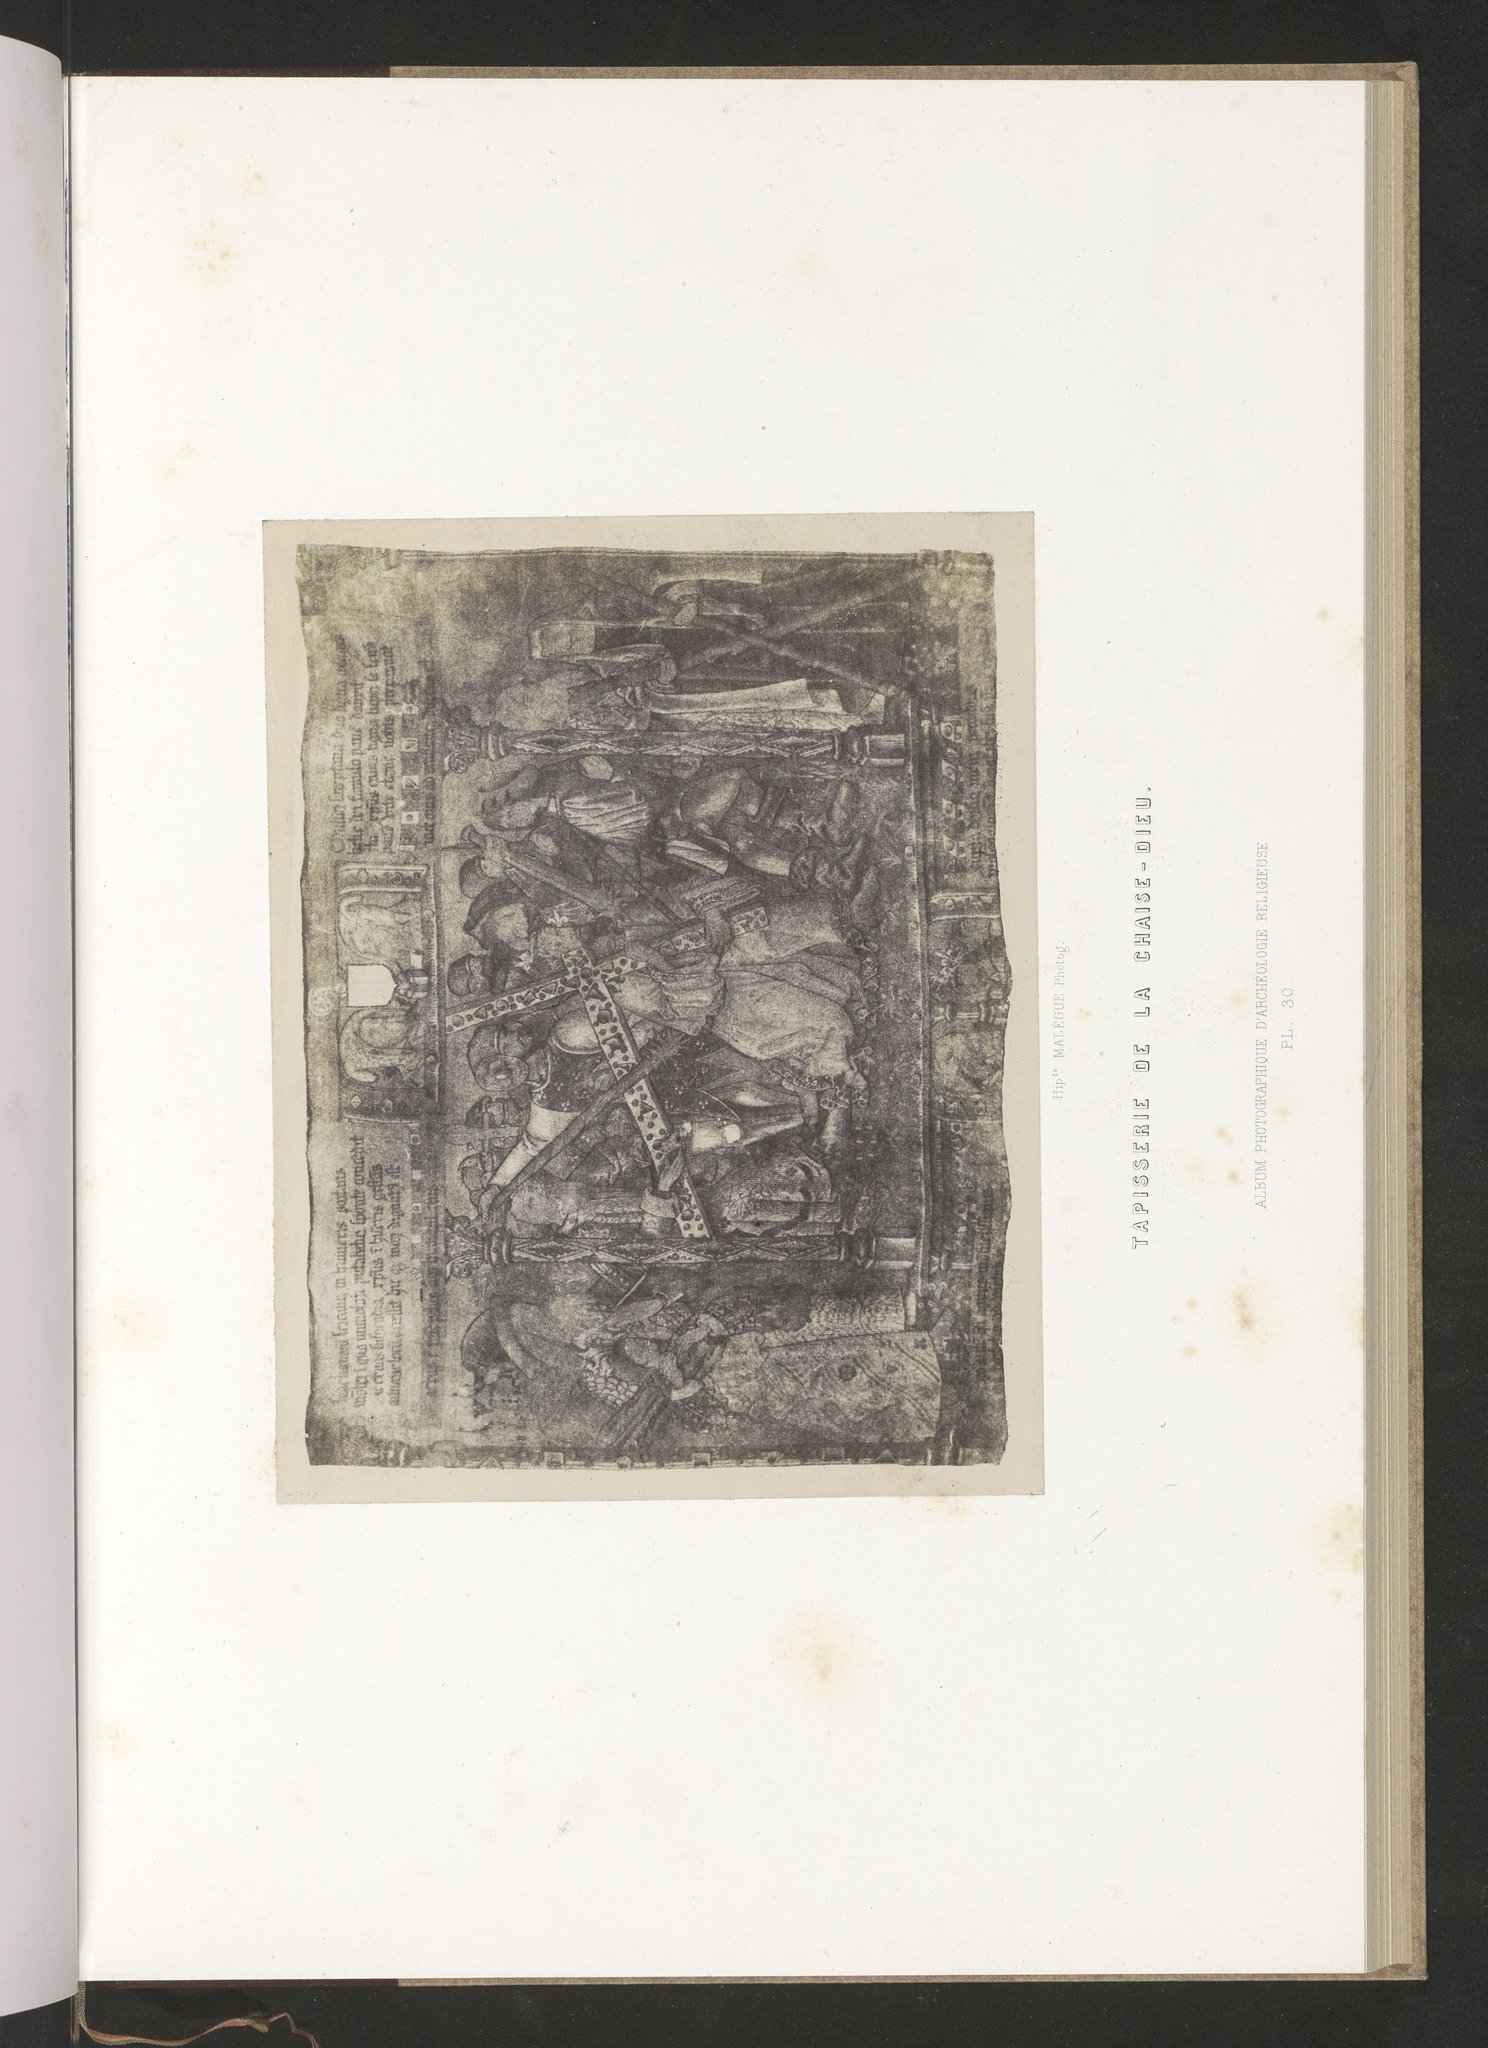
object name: photograph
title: Wandtapijt afkomstig van La Chaise-Dieu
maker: hippolyte malègue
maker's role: archeoloog, fotograaf, schrijver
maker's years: 1825-1901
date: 1850-1857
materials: photographic support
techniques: salted paper print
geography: france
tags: tapestry, carrying of the cross: christ bearing the cross, alone or with the help of others (e.g. simon the cyrenian)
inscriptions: number: ‘PL. 30.’